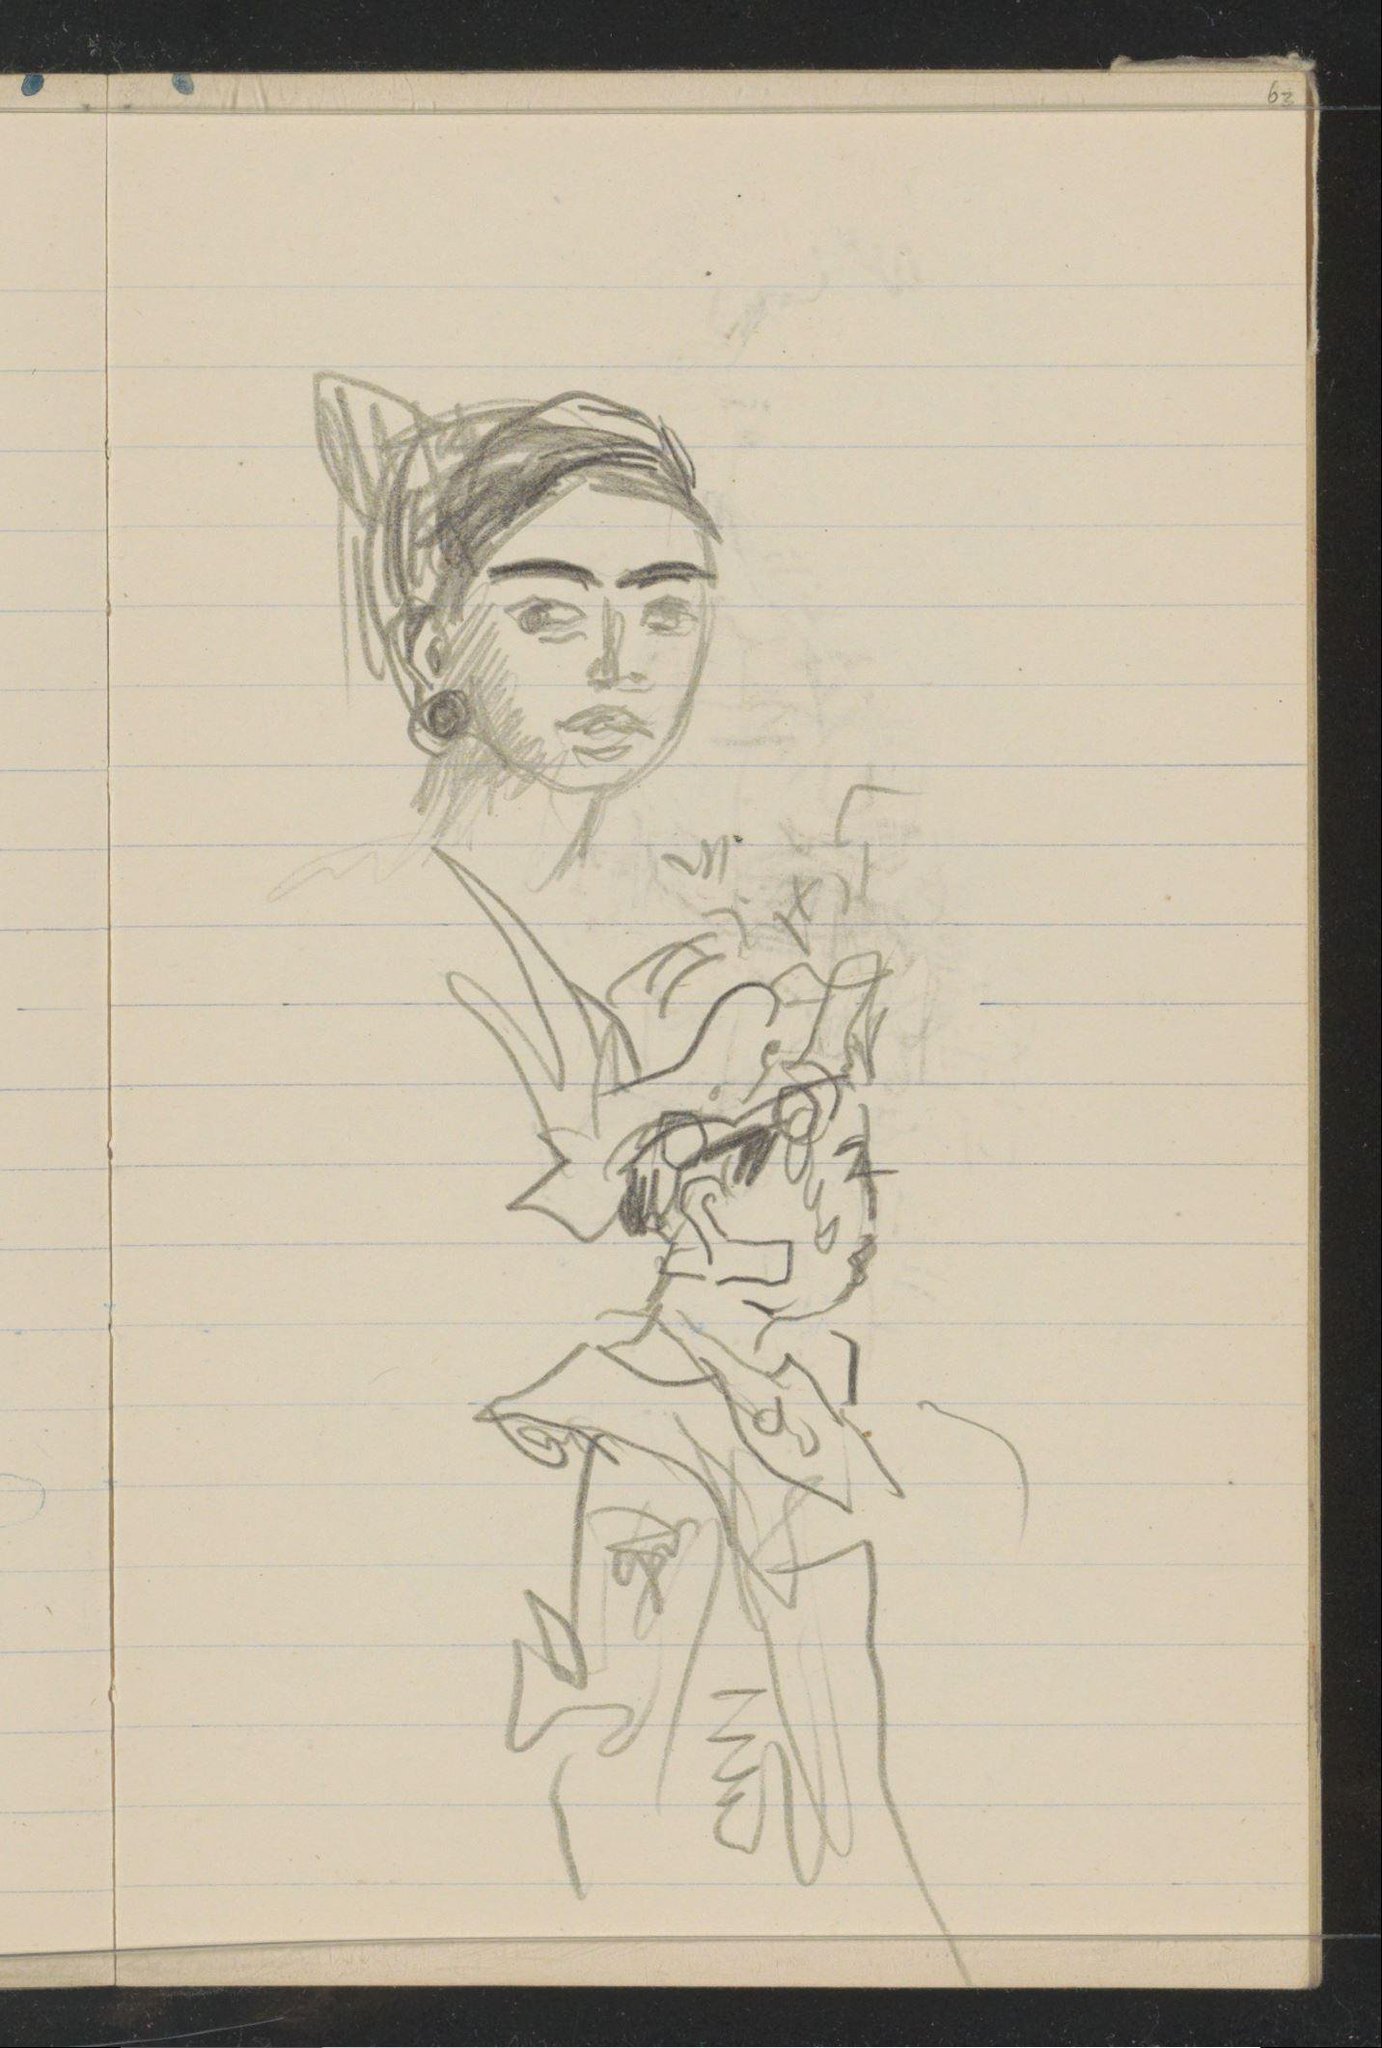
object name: sketchbook leaf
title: Figuurstudies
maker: marius bauer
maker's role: draughtsman, print maker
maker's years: 1867-1932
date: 1931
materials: pencil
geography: indonesia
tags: asiatic races and peoples, adult woman, head-gear, folk costume, regional costume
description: Onder andere een vrouwenkop en een figuur met een traditioneel hoofddeksel. Pagina 63 uit een schetsboek met 74 bladen.